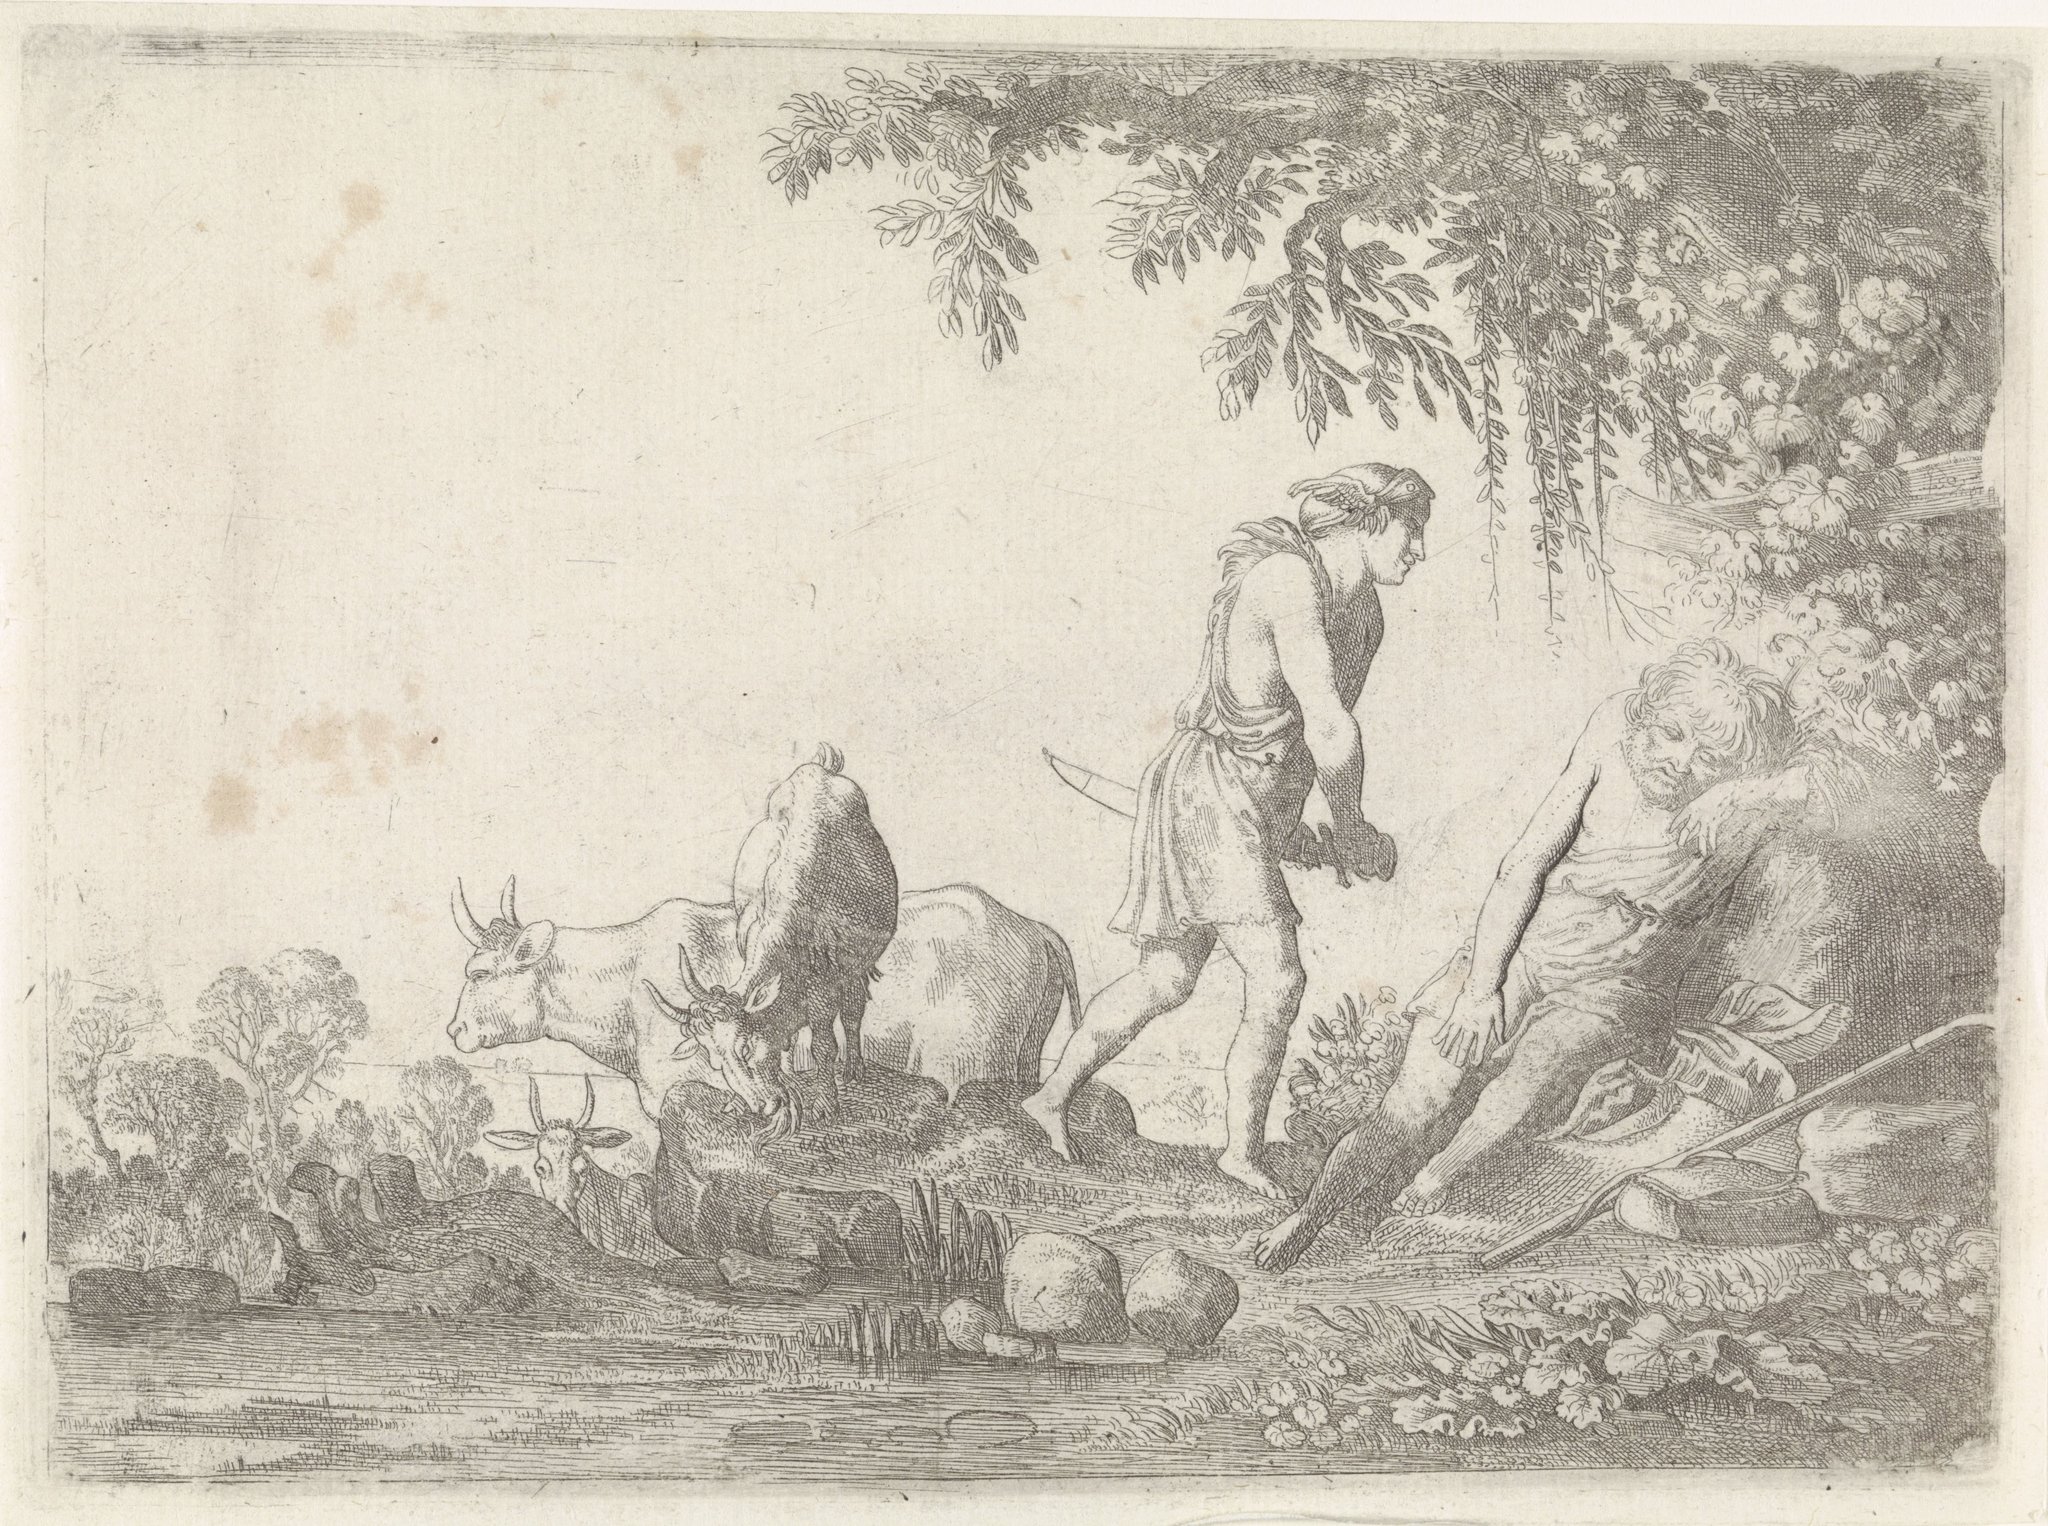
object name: print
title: Mercurius maakt aanstalten om Argus te doden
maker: moyses van wtenbrouck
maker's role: painter, print maker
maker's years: 1590-1647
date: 1618-1628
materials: paper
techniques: engraving, etching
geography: the hague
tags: mercury beheads argus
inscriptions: collector's mark: Lugt 240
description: Mercurius loopt, zijn zwaard trekkend, op de slapende Argus af. Scène uit Ovidius’ Metamorfosen (Met. I, 715-719).